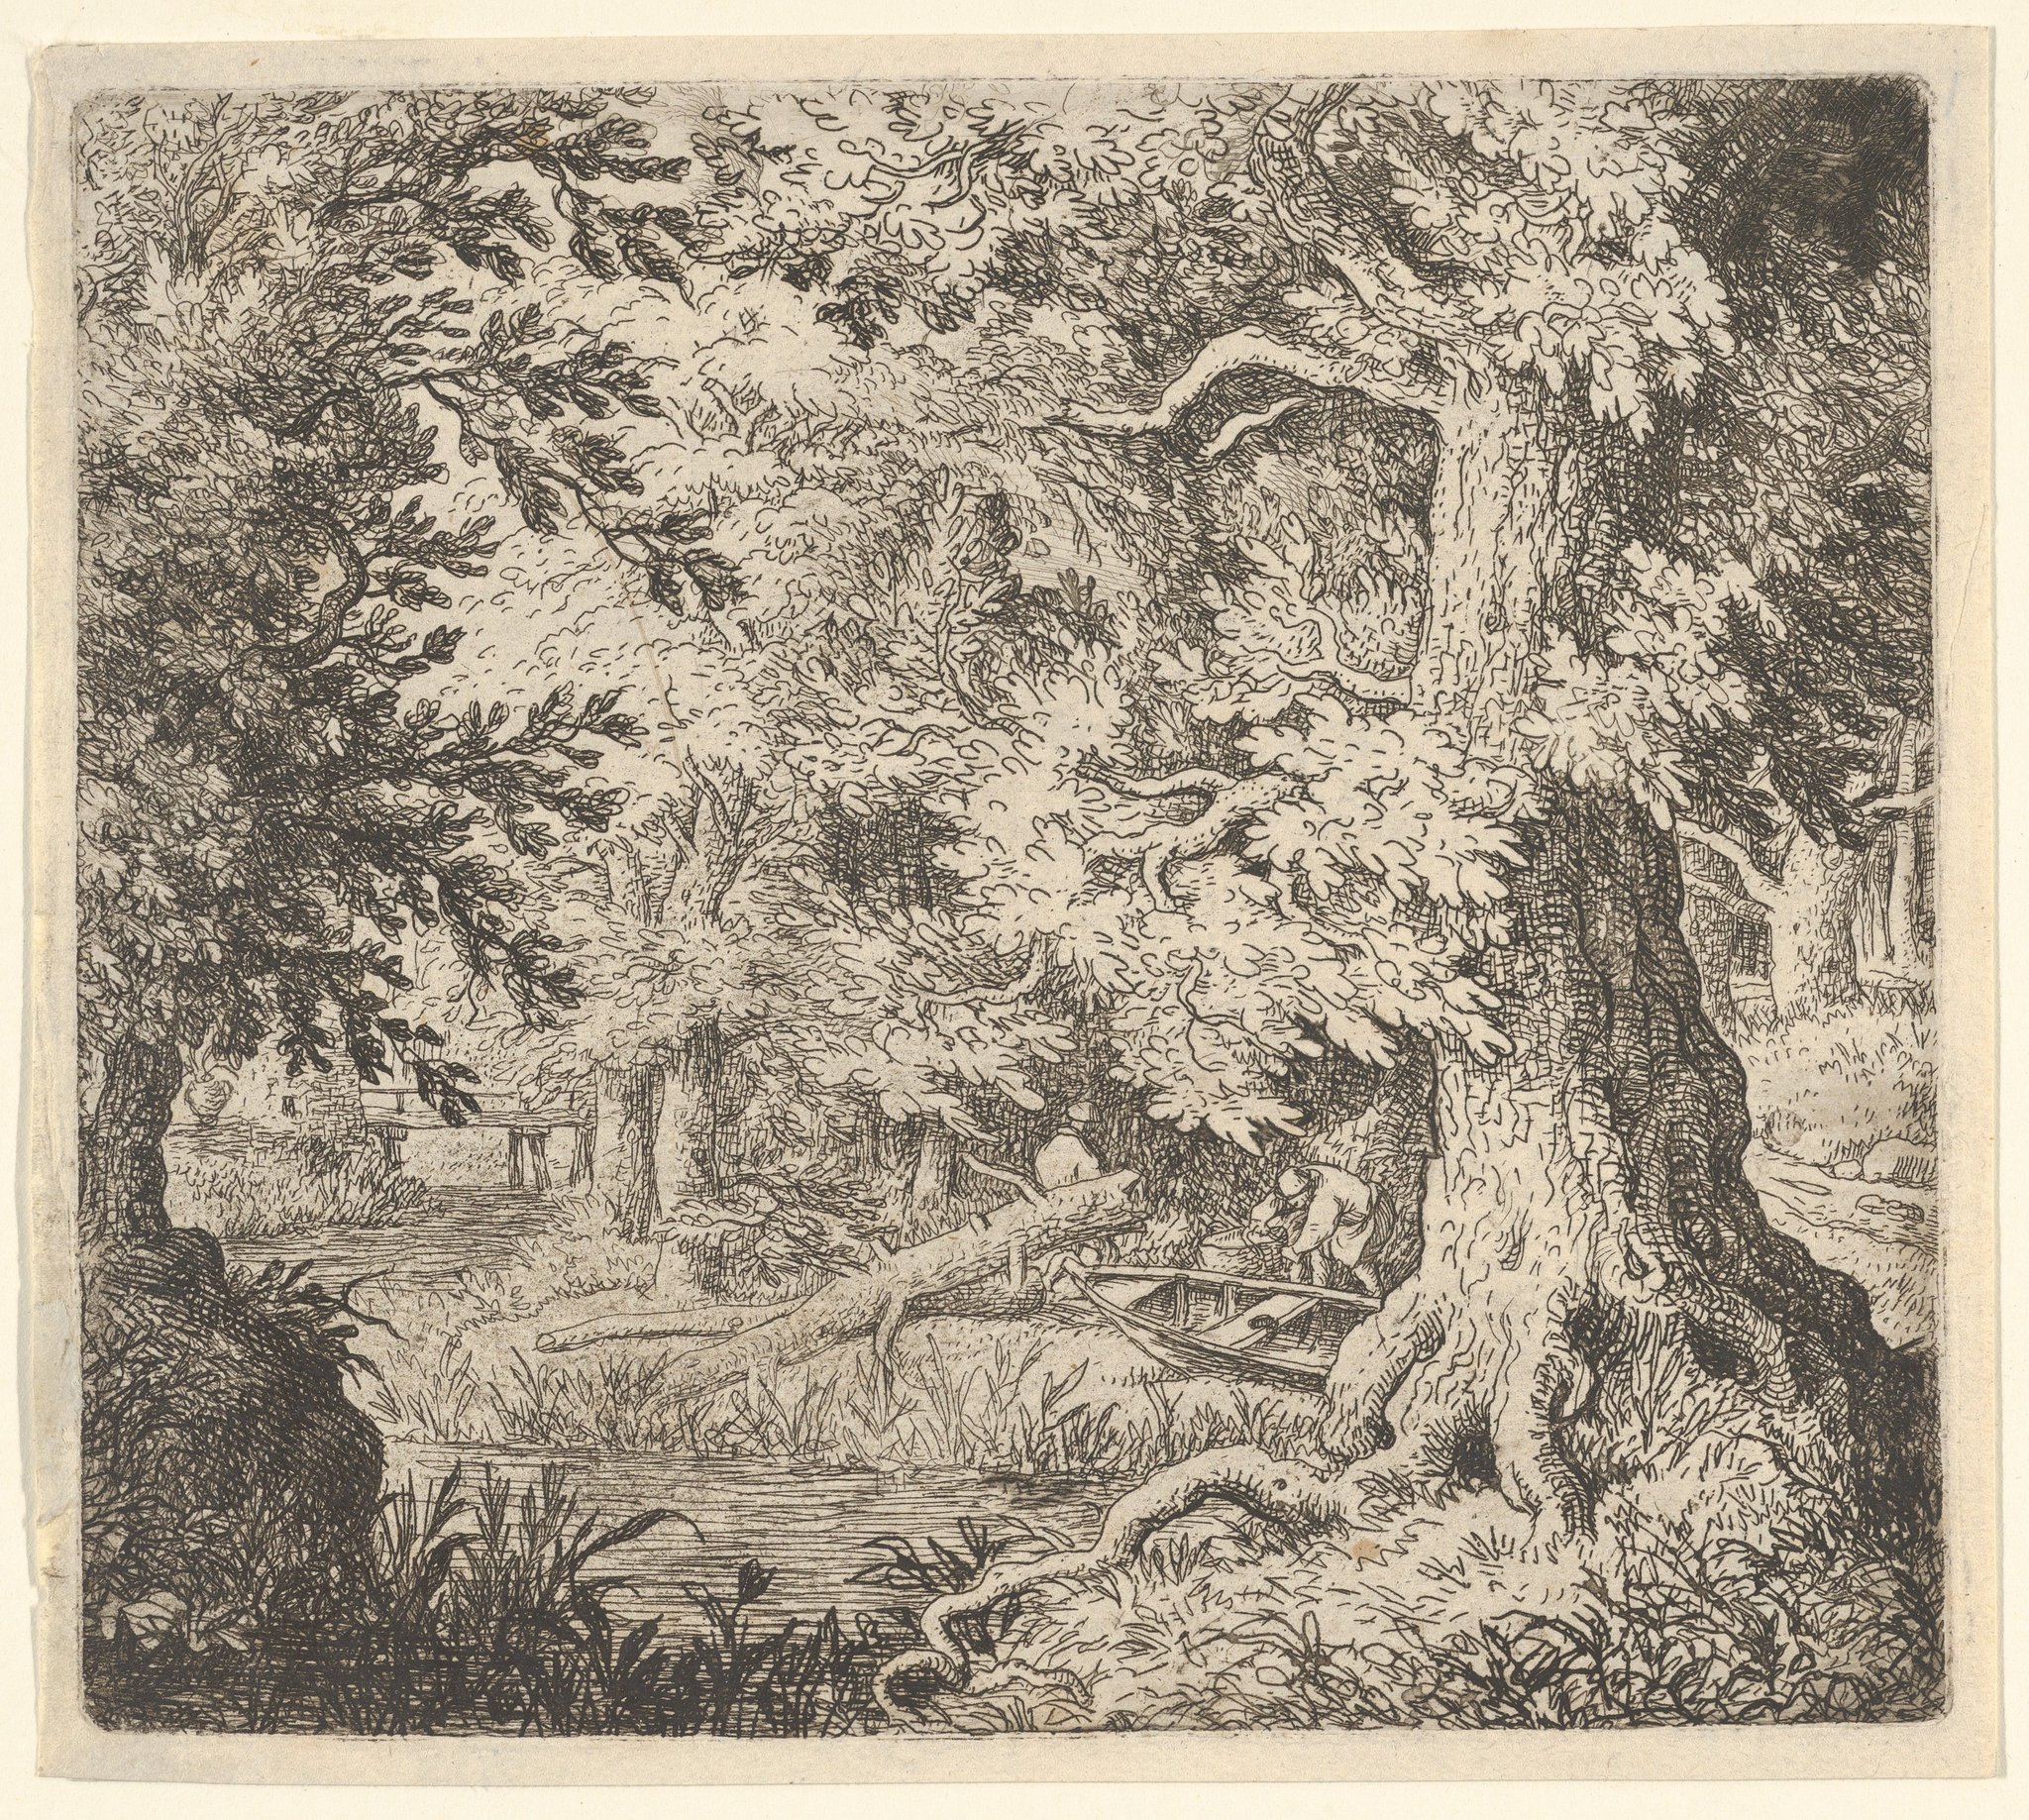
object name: print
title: The Brook in the Wood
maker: allart van everdingen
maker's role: artist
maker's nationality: dutch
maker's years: 1621-1675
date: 1621-1675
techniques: engraving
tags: men,forests,boats